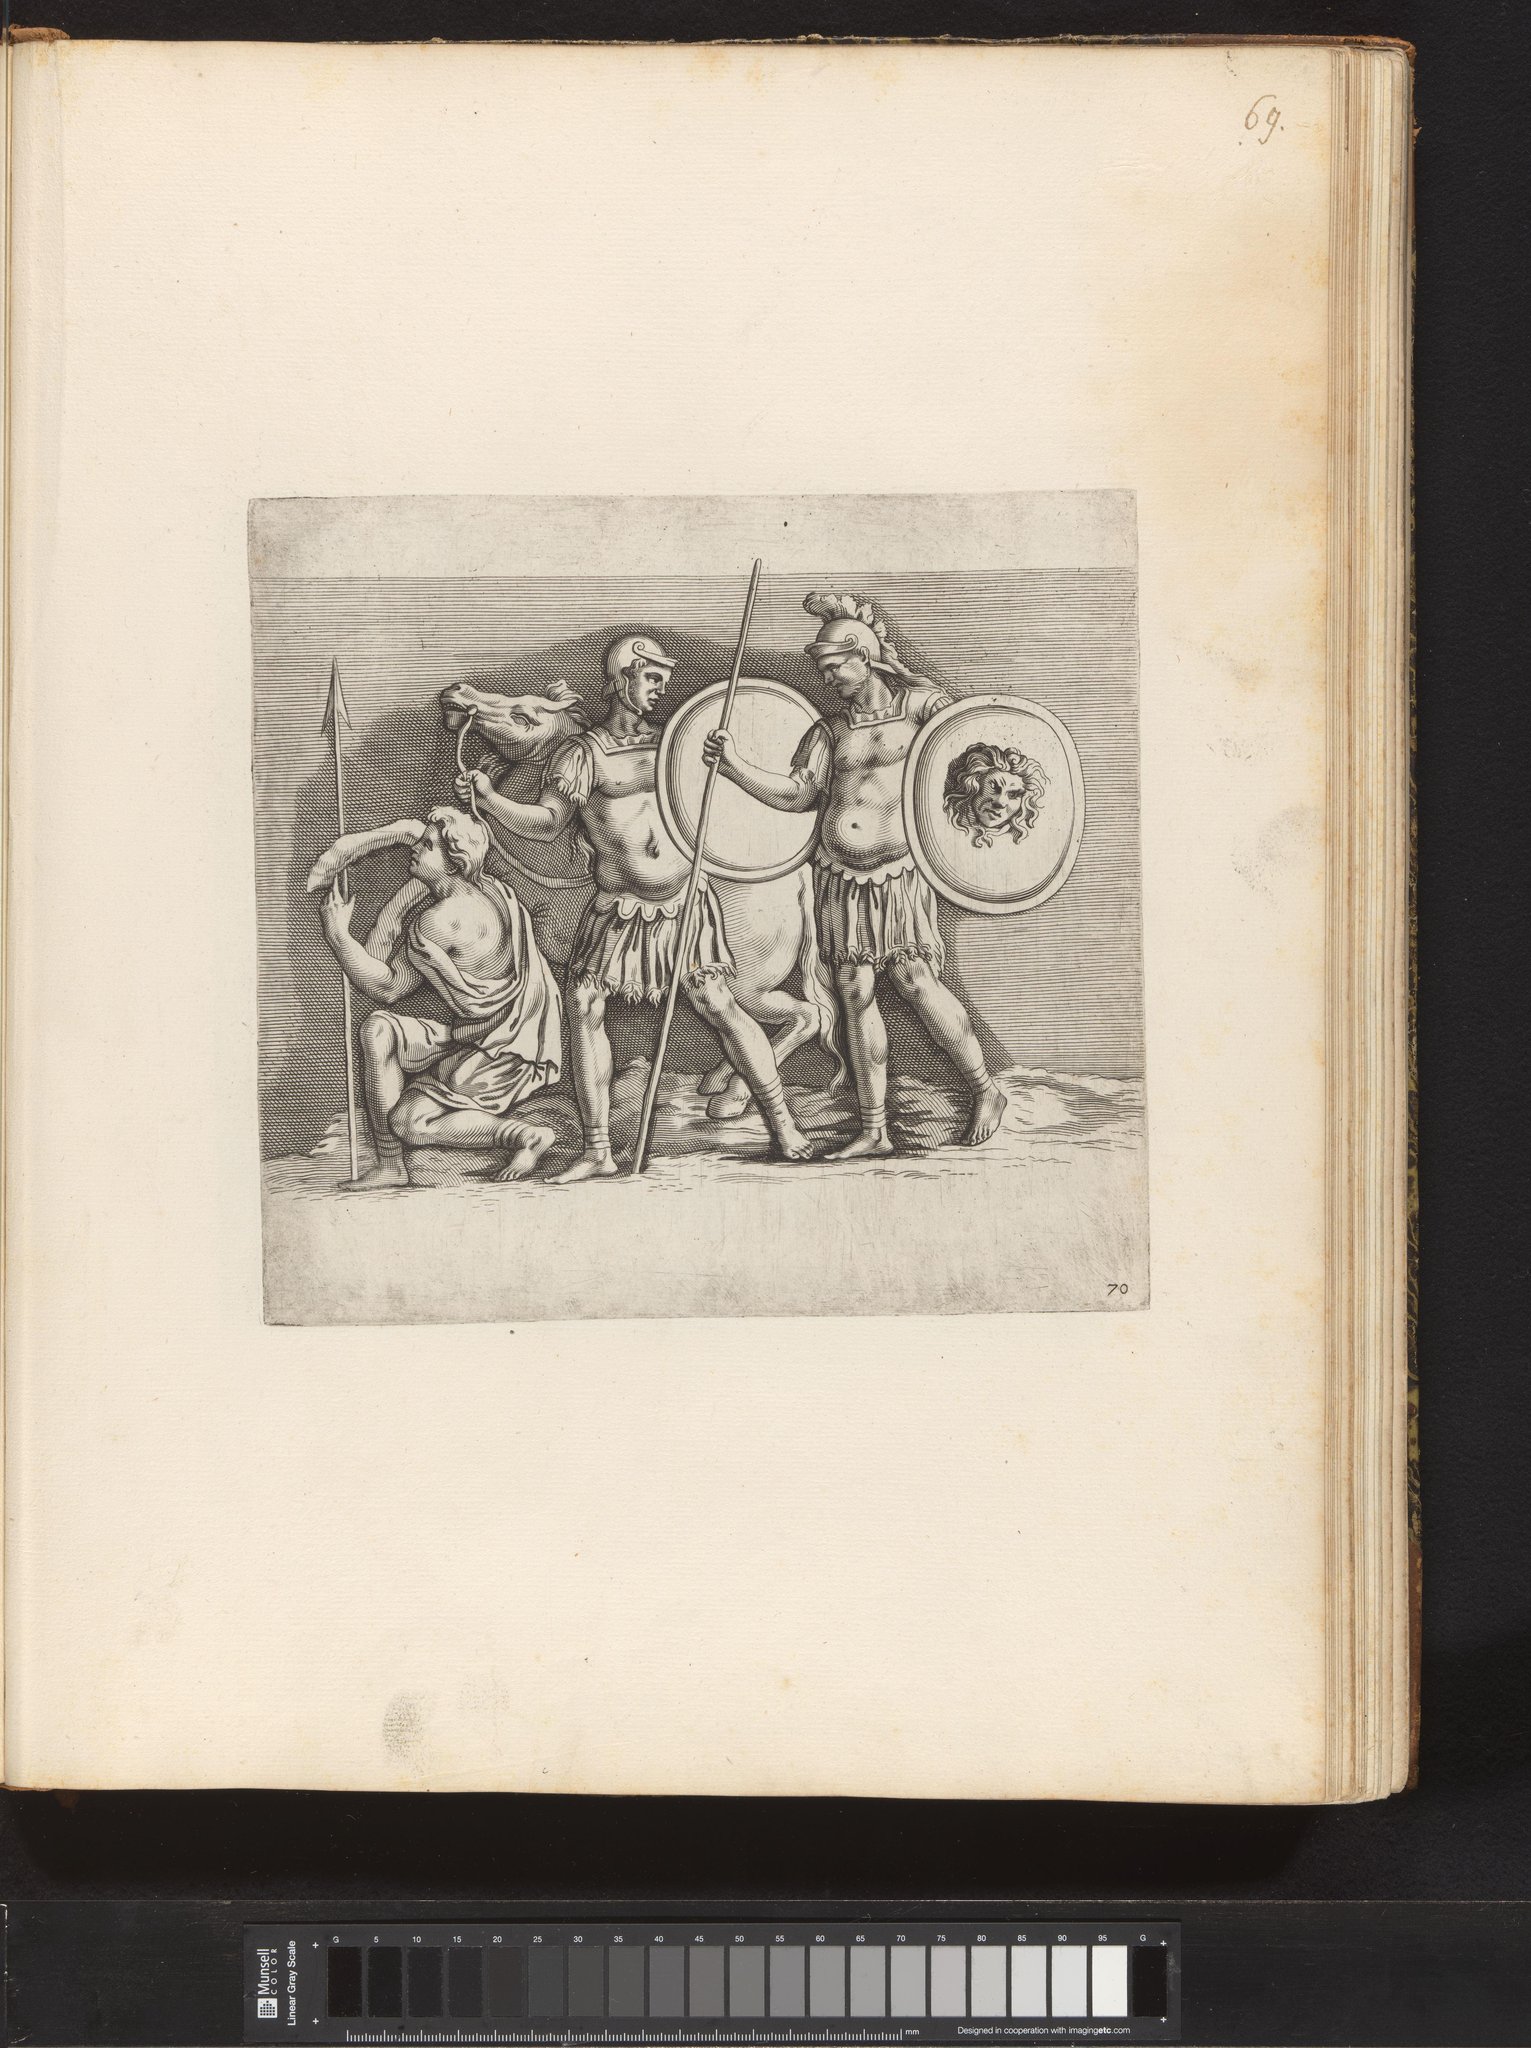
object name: album leaf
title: Galleria Giustiniana del Marchese Vincenzo Giustiniani II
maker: valérien regnard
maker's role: print maker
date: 1636-1647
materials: paper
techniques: engraving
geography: rome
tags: thiasos, i.e. bacchus' revel-rout, bacchanal without bacchus, piece of sculpture, reproduction of a piece of sculpture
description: Bas-reliëf met bacchanaal. Midden onder op het reliëf het wapenschild van Vincenzo Giustiniani. Prent maakt deel uit van een album met een serie prenten naar de sculpturen in de verzameling in de Galleria Giustiniani te Rome.